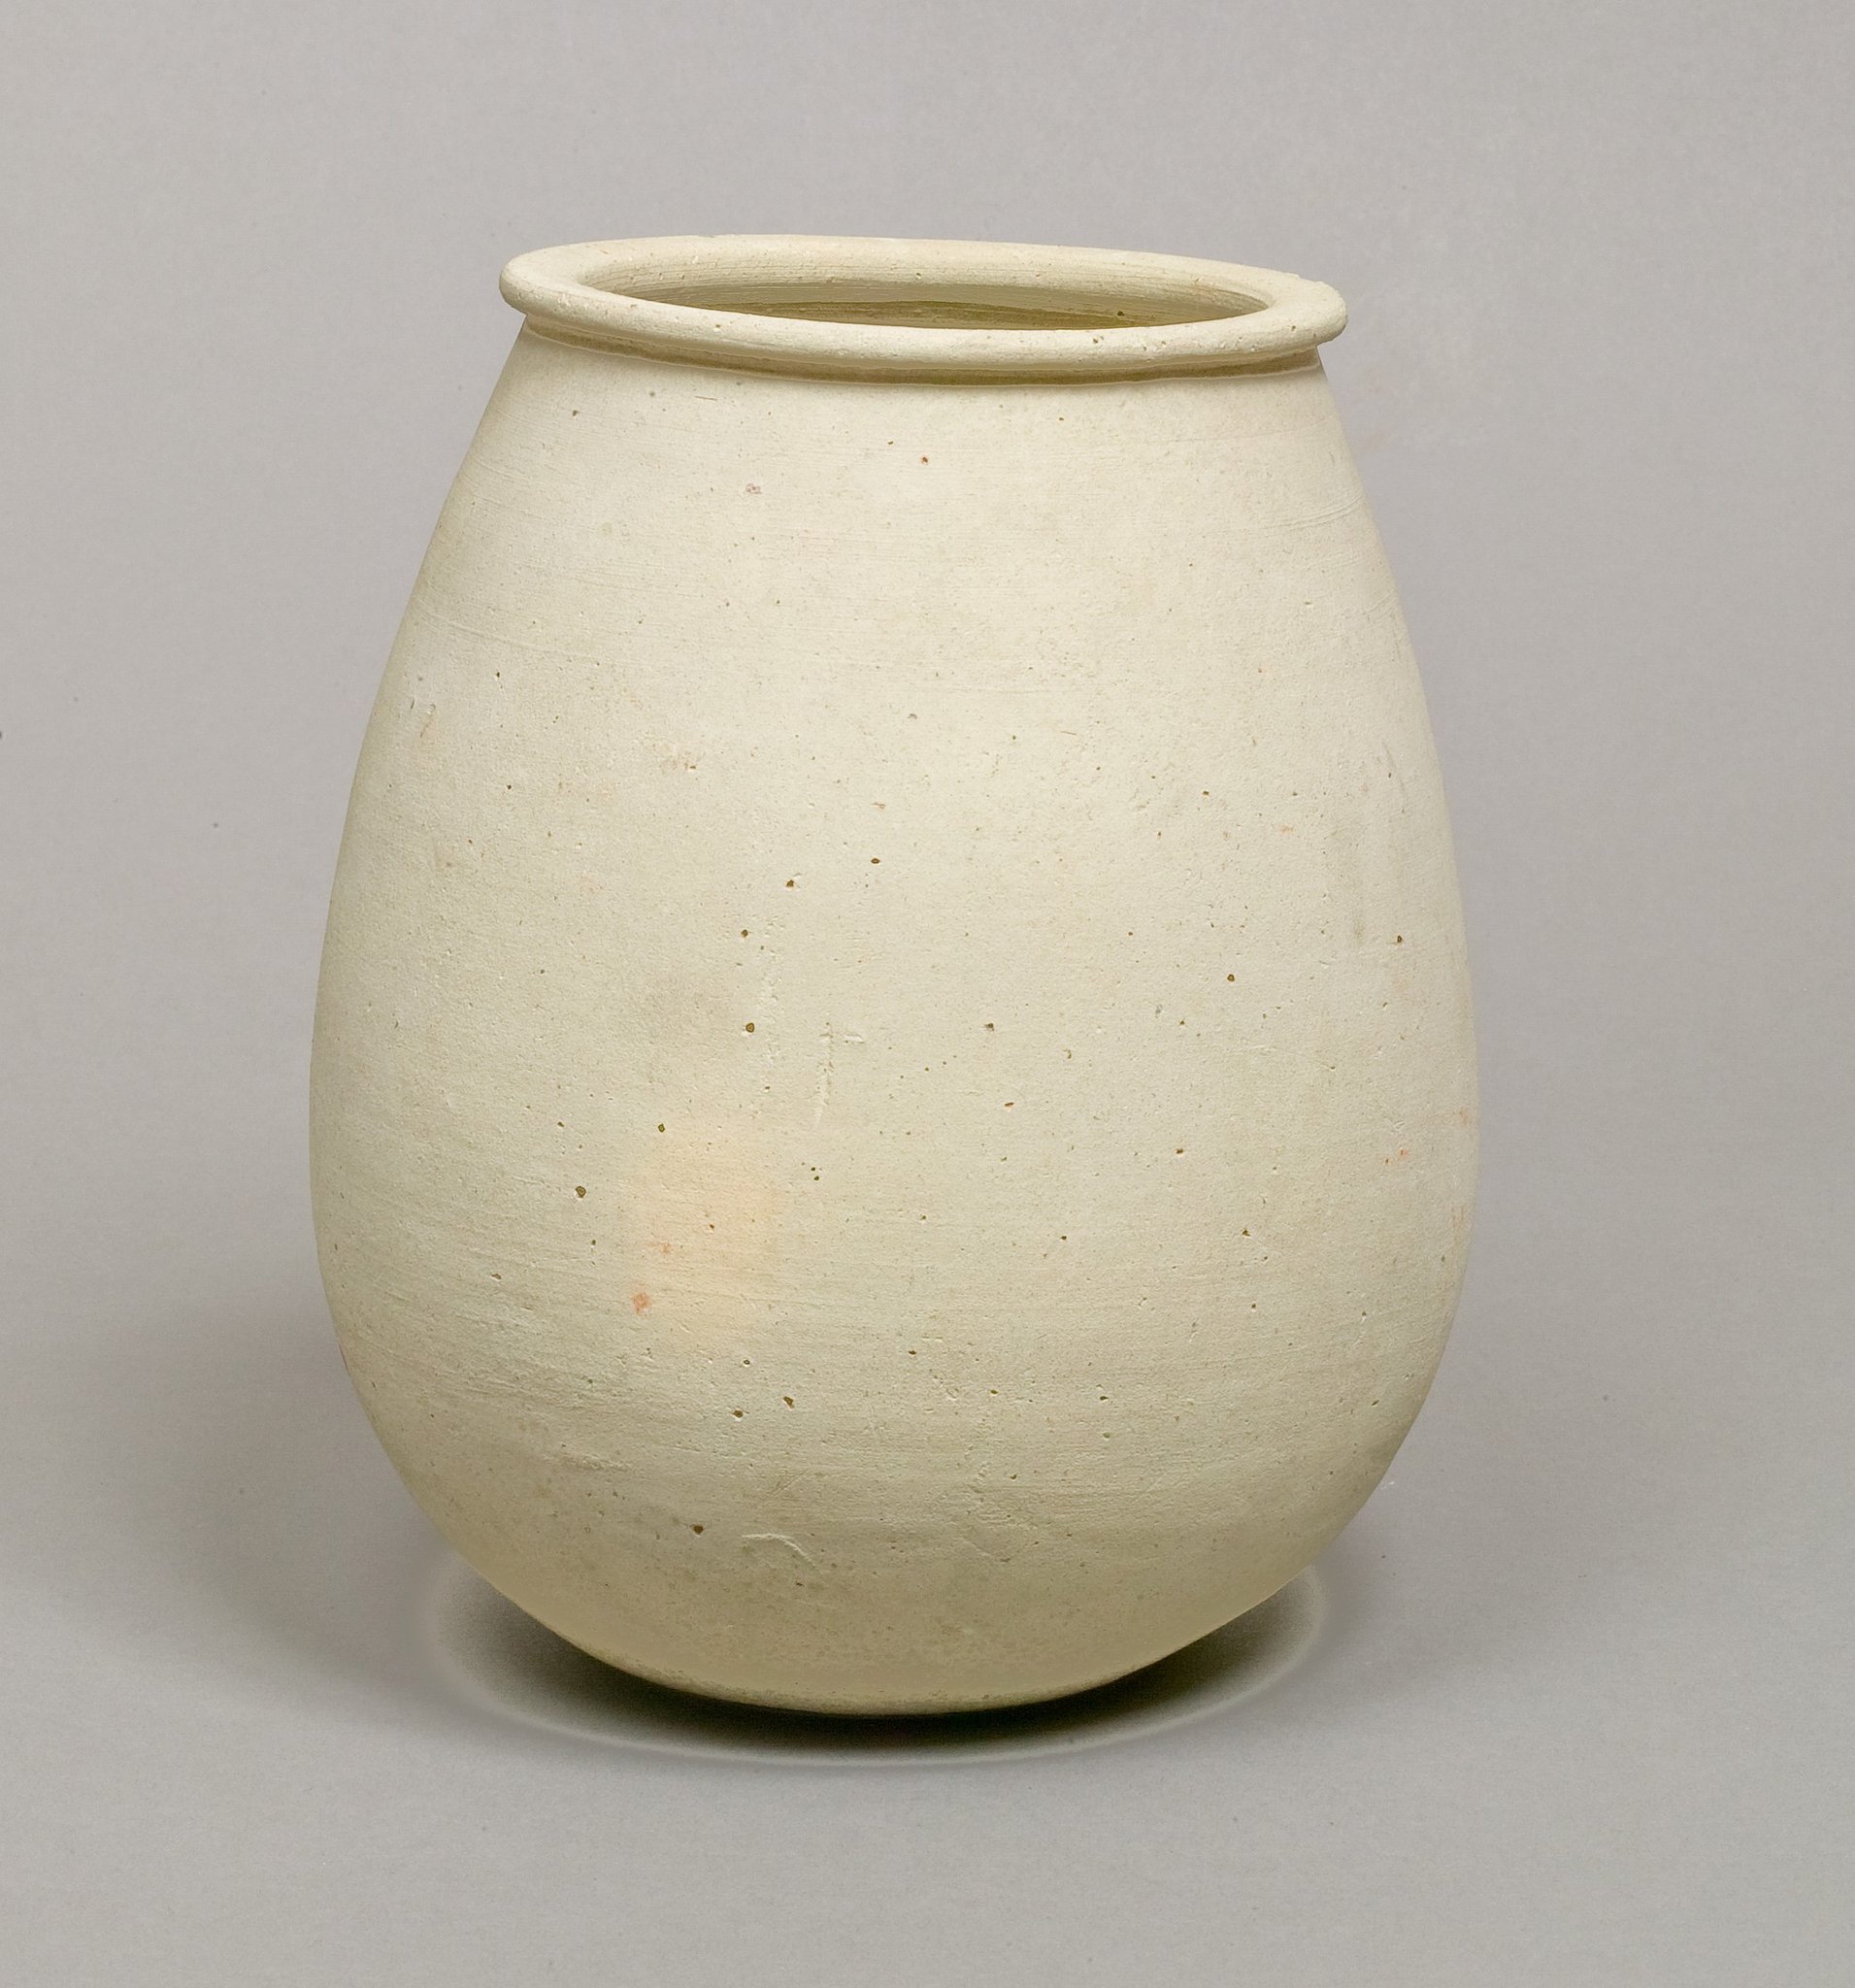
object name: jar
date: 1981-1550 BCE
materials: clay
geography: egypt